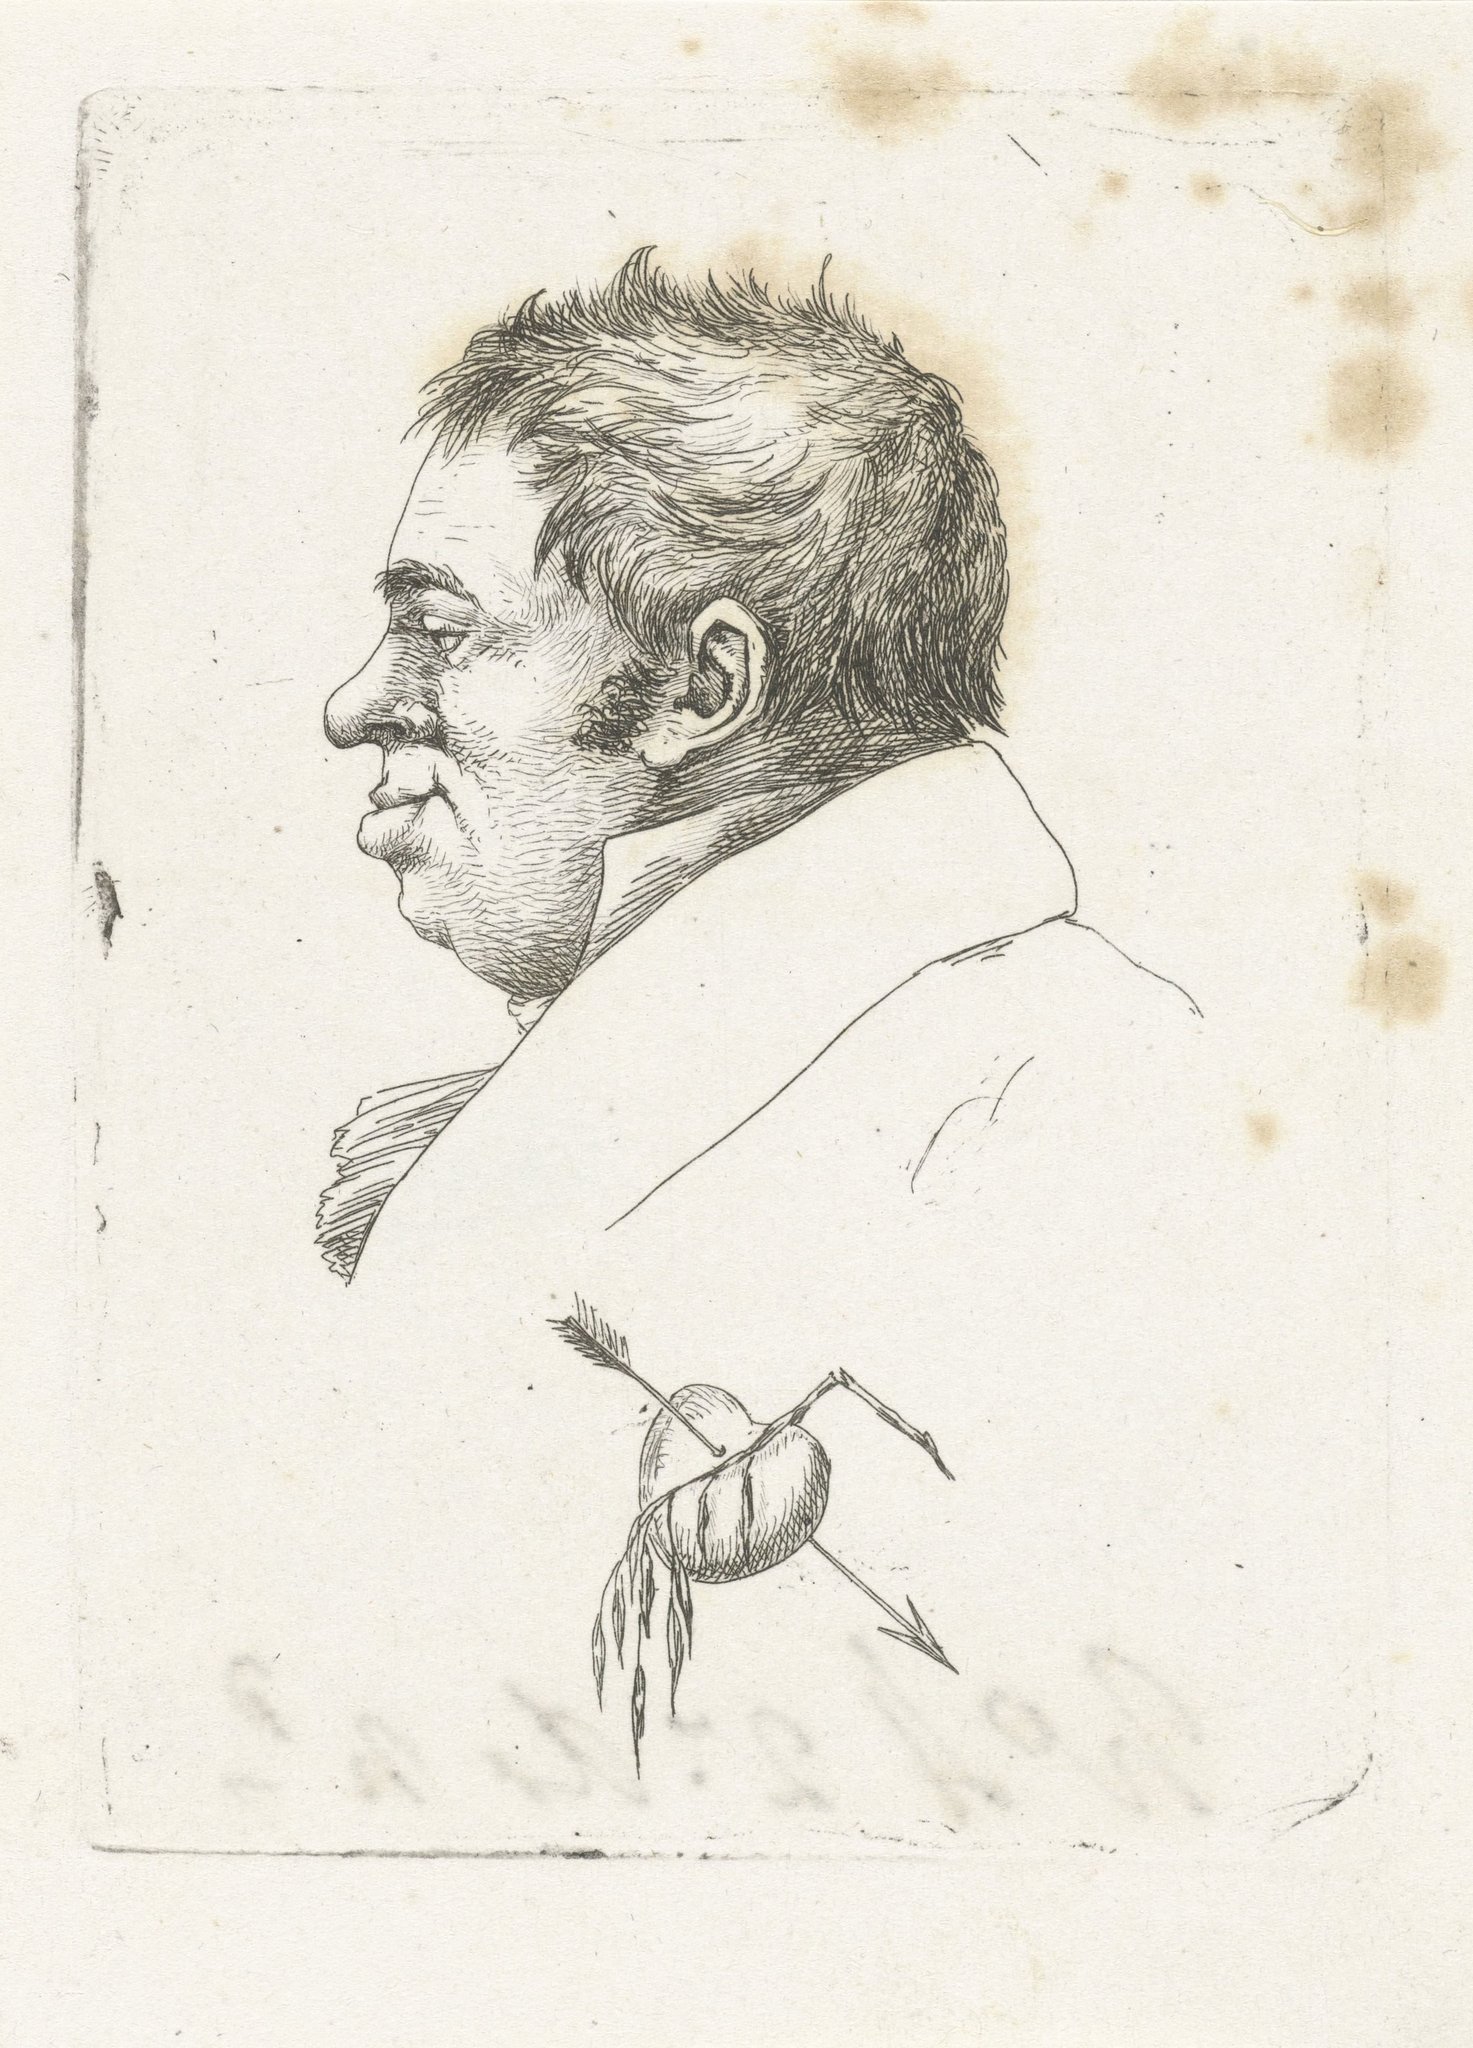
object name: print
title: Portret van Jantje de Wit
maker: jean zacherie mazel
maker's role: draughtsman, print maker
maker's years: 1792-1884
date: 1802-1884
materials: paper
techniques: etching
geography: netherlands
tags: heart symbolism, archer's weapons: arrow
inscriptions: inscription: ‘WH 2: d ...’, collector's mark: Lugt 2760, collector's mark: Lugt 2228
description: Portret van Jantje de Wit, notaris te Amsterdam, en profil. Midden onder een met pijl doorstoken hart en een geknakte tak met hangende bladeren.